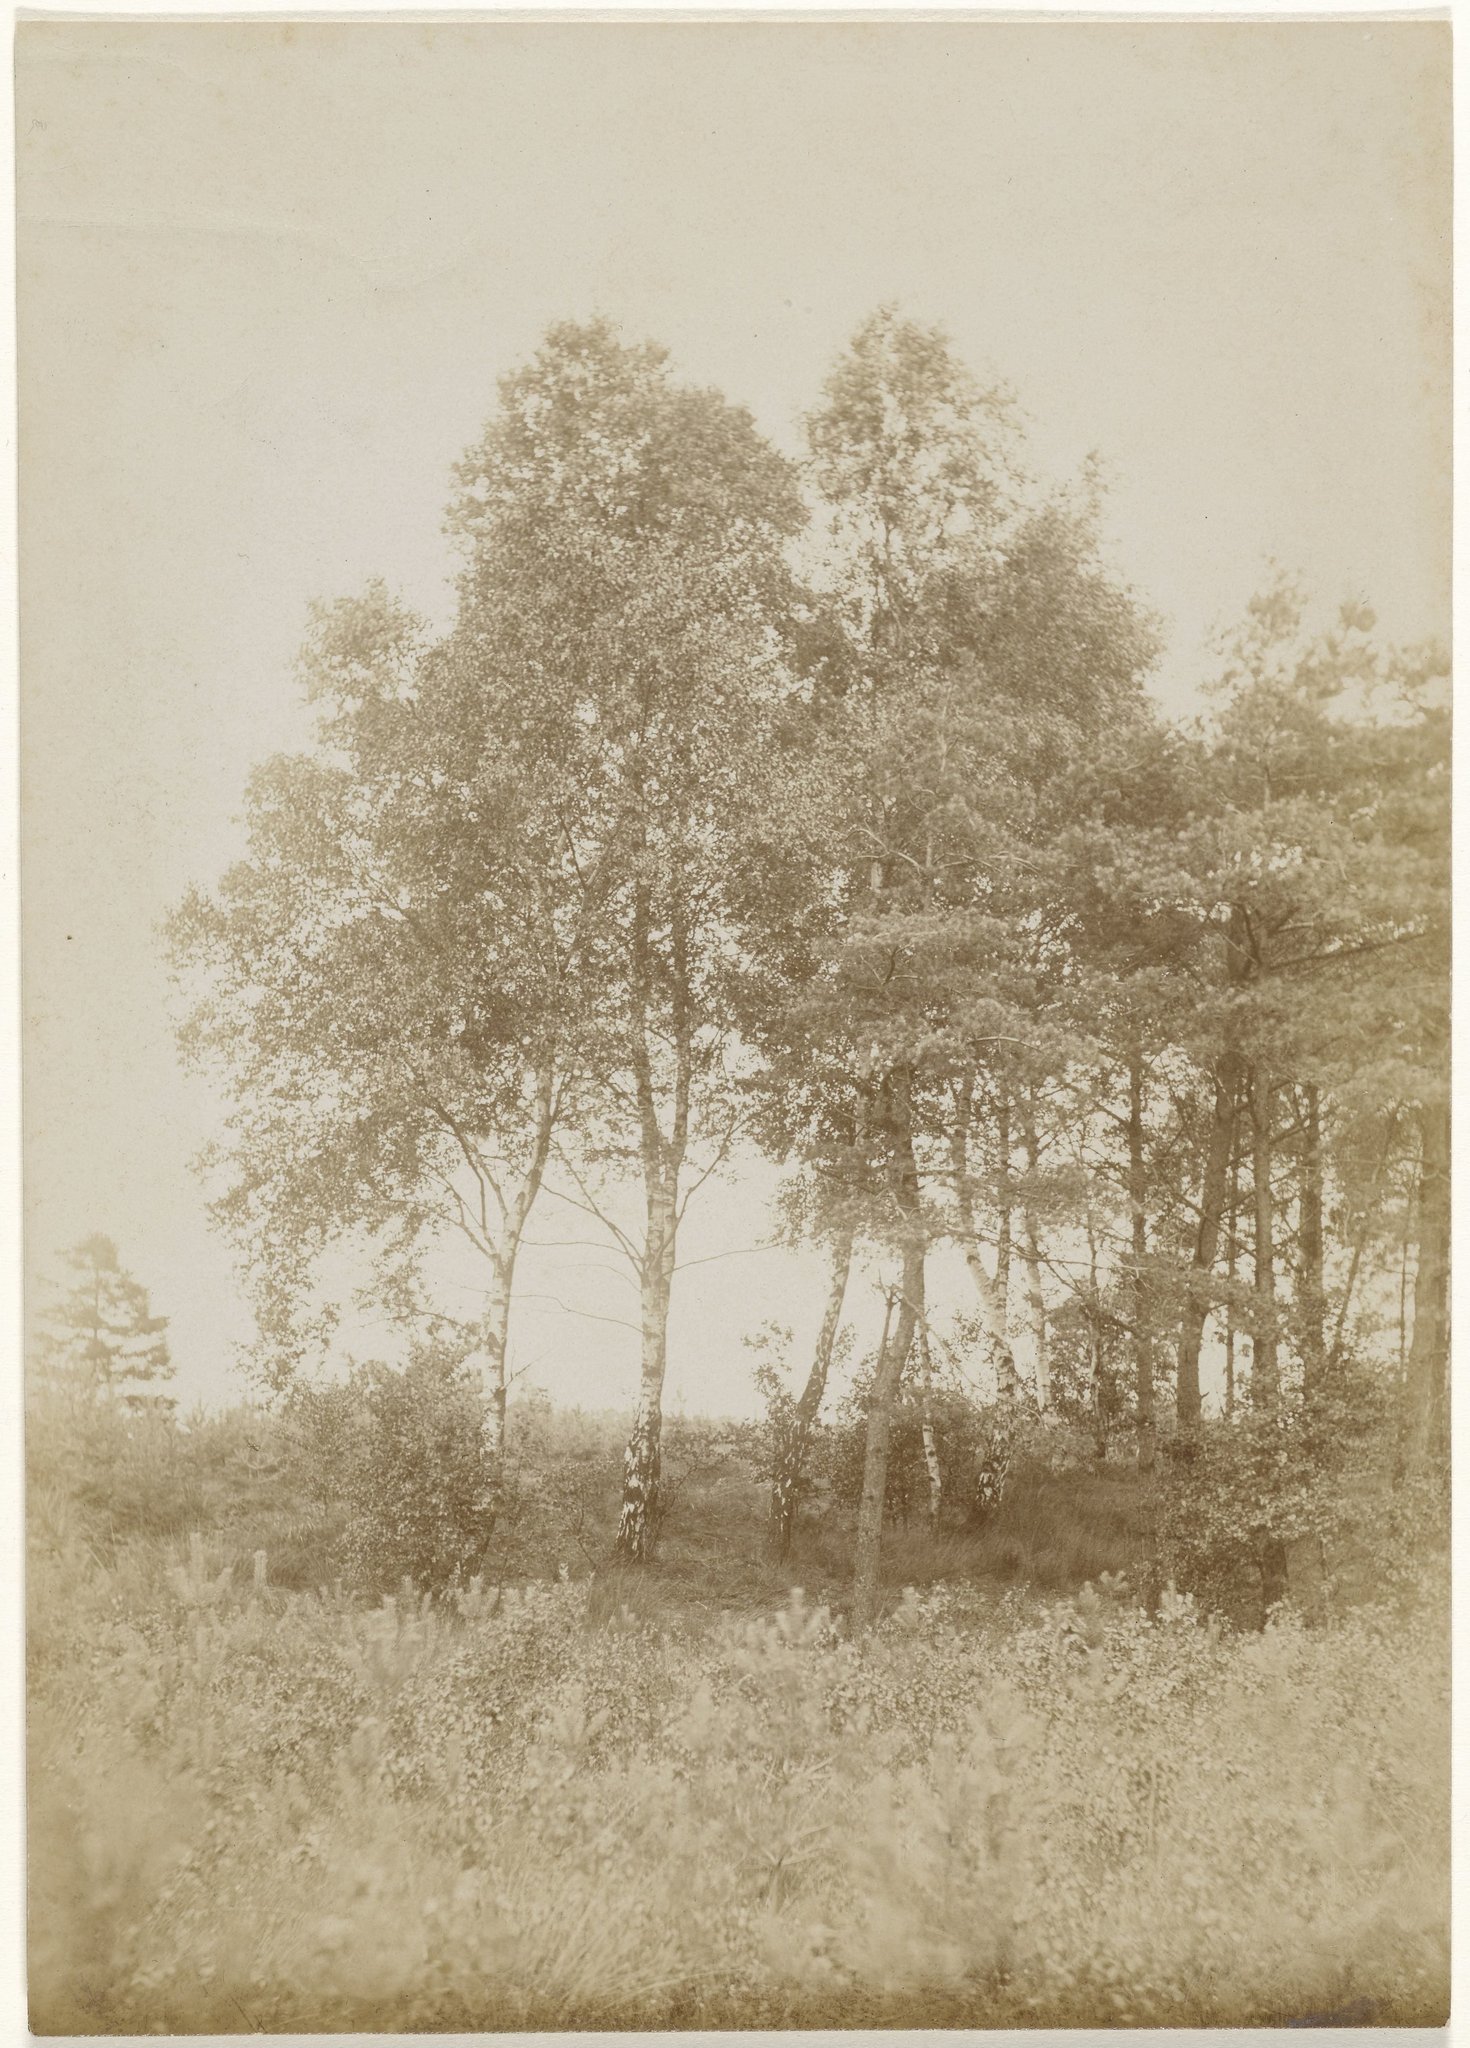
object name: photograph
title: Landschap met bomen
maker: Anonymous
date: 1880-1910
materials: paper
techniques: collodion silver print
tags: landscapes in the temperate zone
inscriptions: name: ‘VOSMAER’